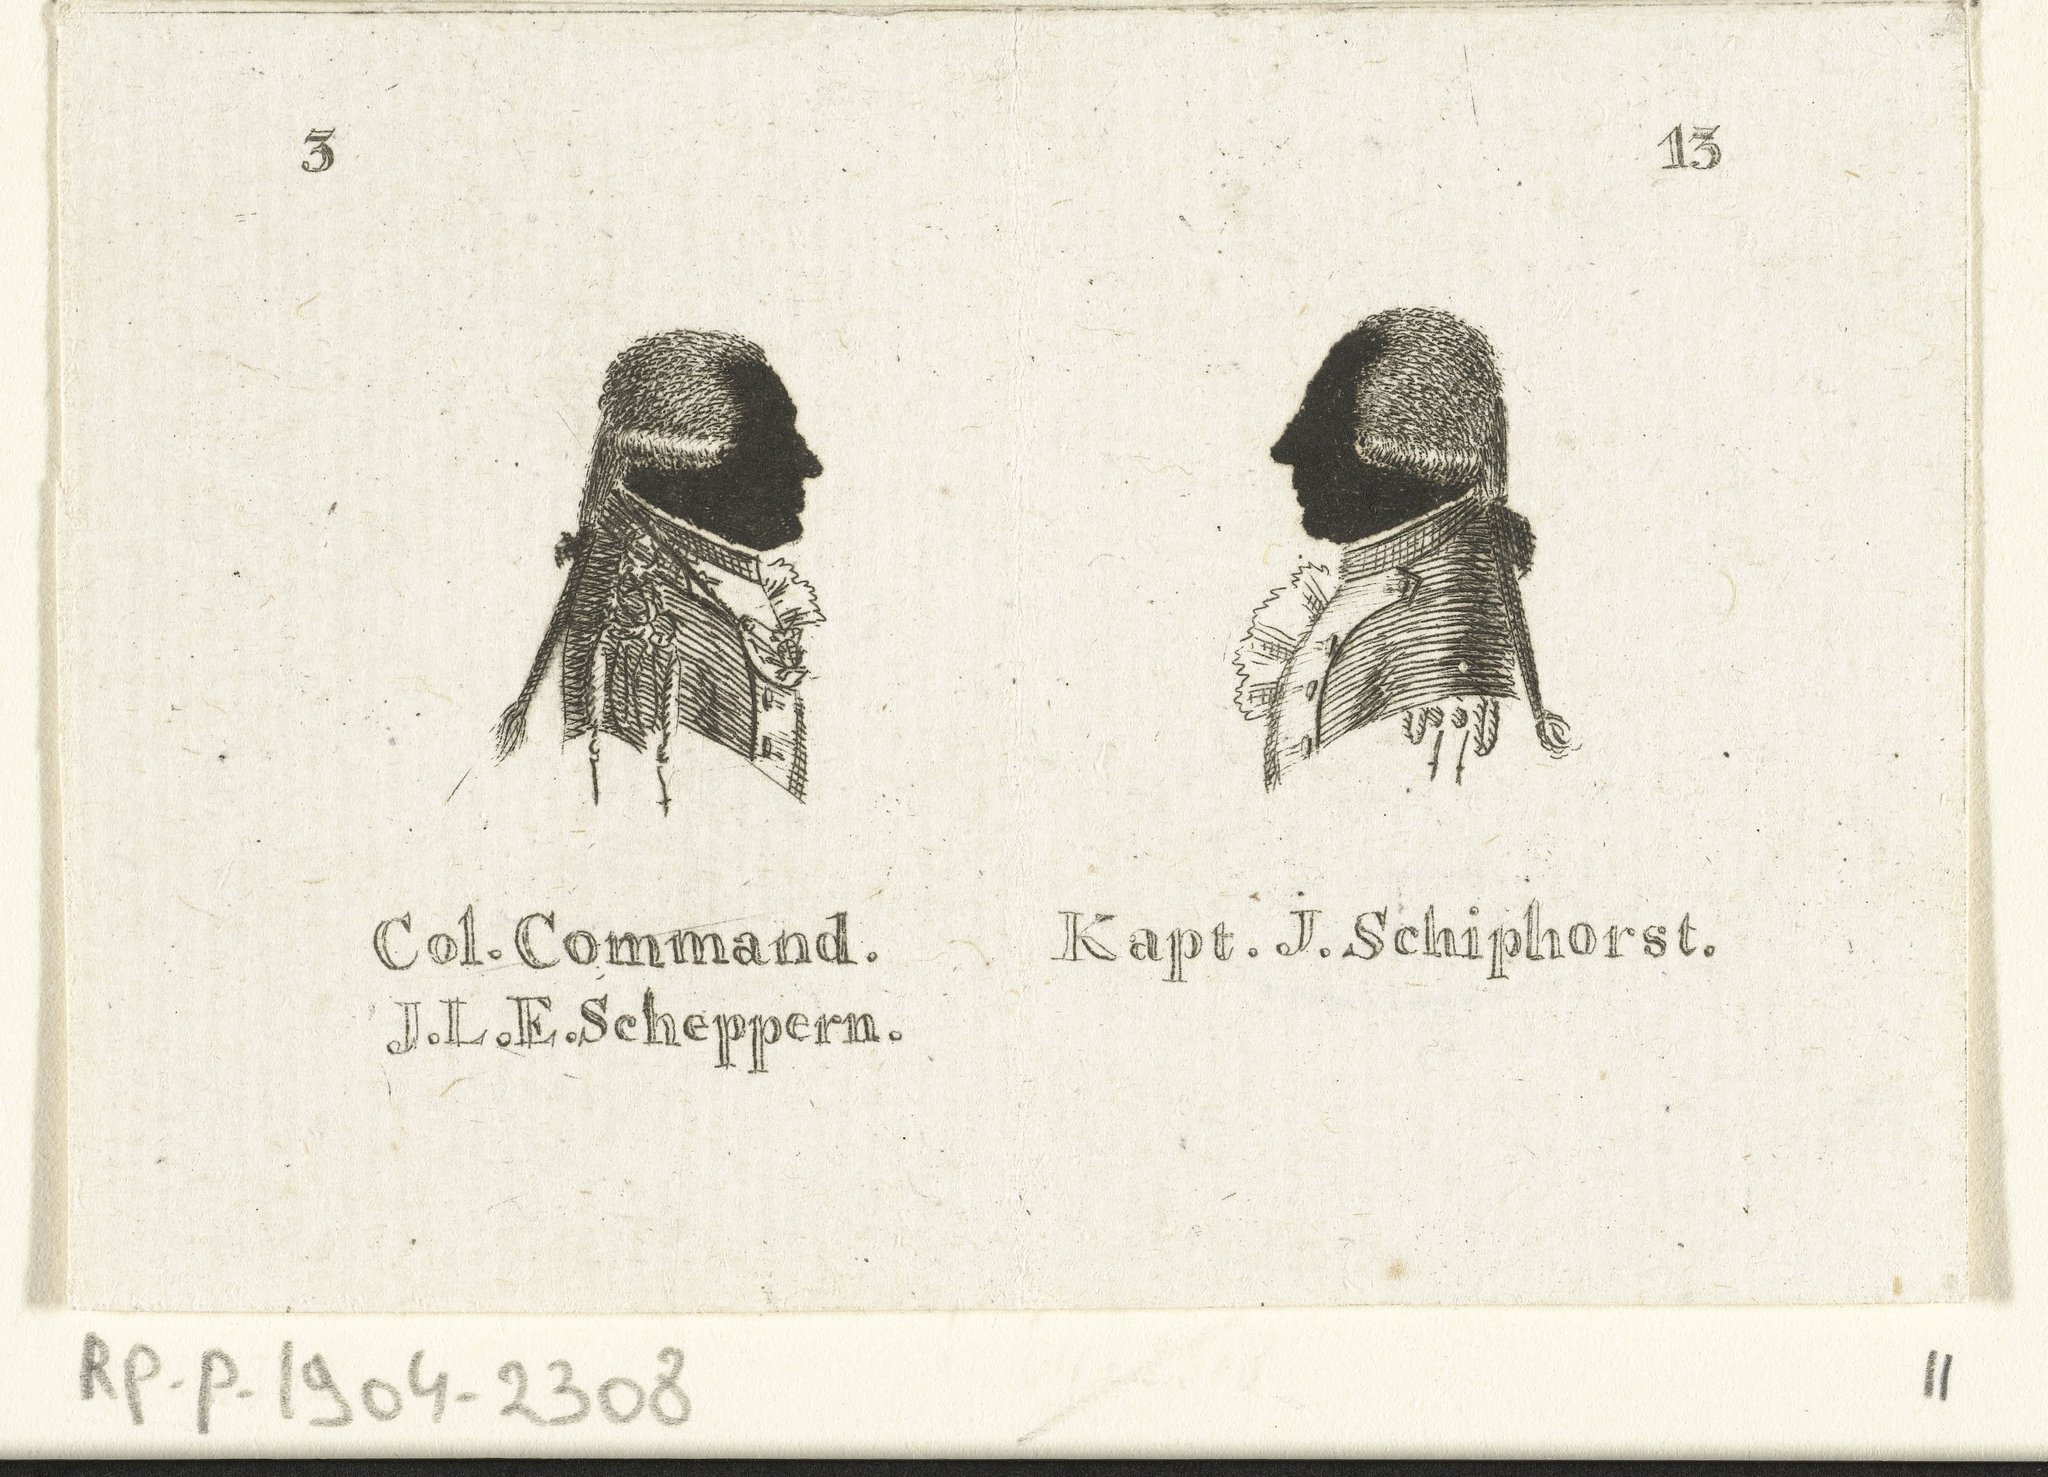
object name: book illustration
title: Zakboekje van de helden van de Willemstad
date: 1794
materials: paper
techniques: etching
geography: amsterdam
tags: j.l.e. scheppern, kapitein, j. schiphorst, beleg van willemstad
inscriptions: collector's mark: Lugt 2228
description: Twee silhouetportretten uit een boekje over de soldaten die Willemstad hebben verdedigd in 1793. De linker is van commandant J.L.E. Scheppern met buste naar rechts. De rechter is van kapitein J. Schiphorst met buste naar links. De prent heeft een onderschrift met de namen van de geportretteerde militairen.